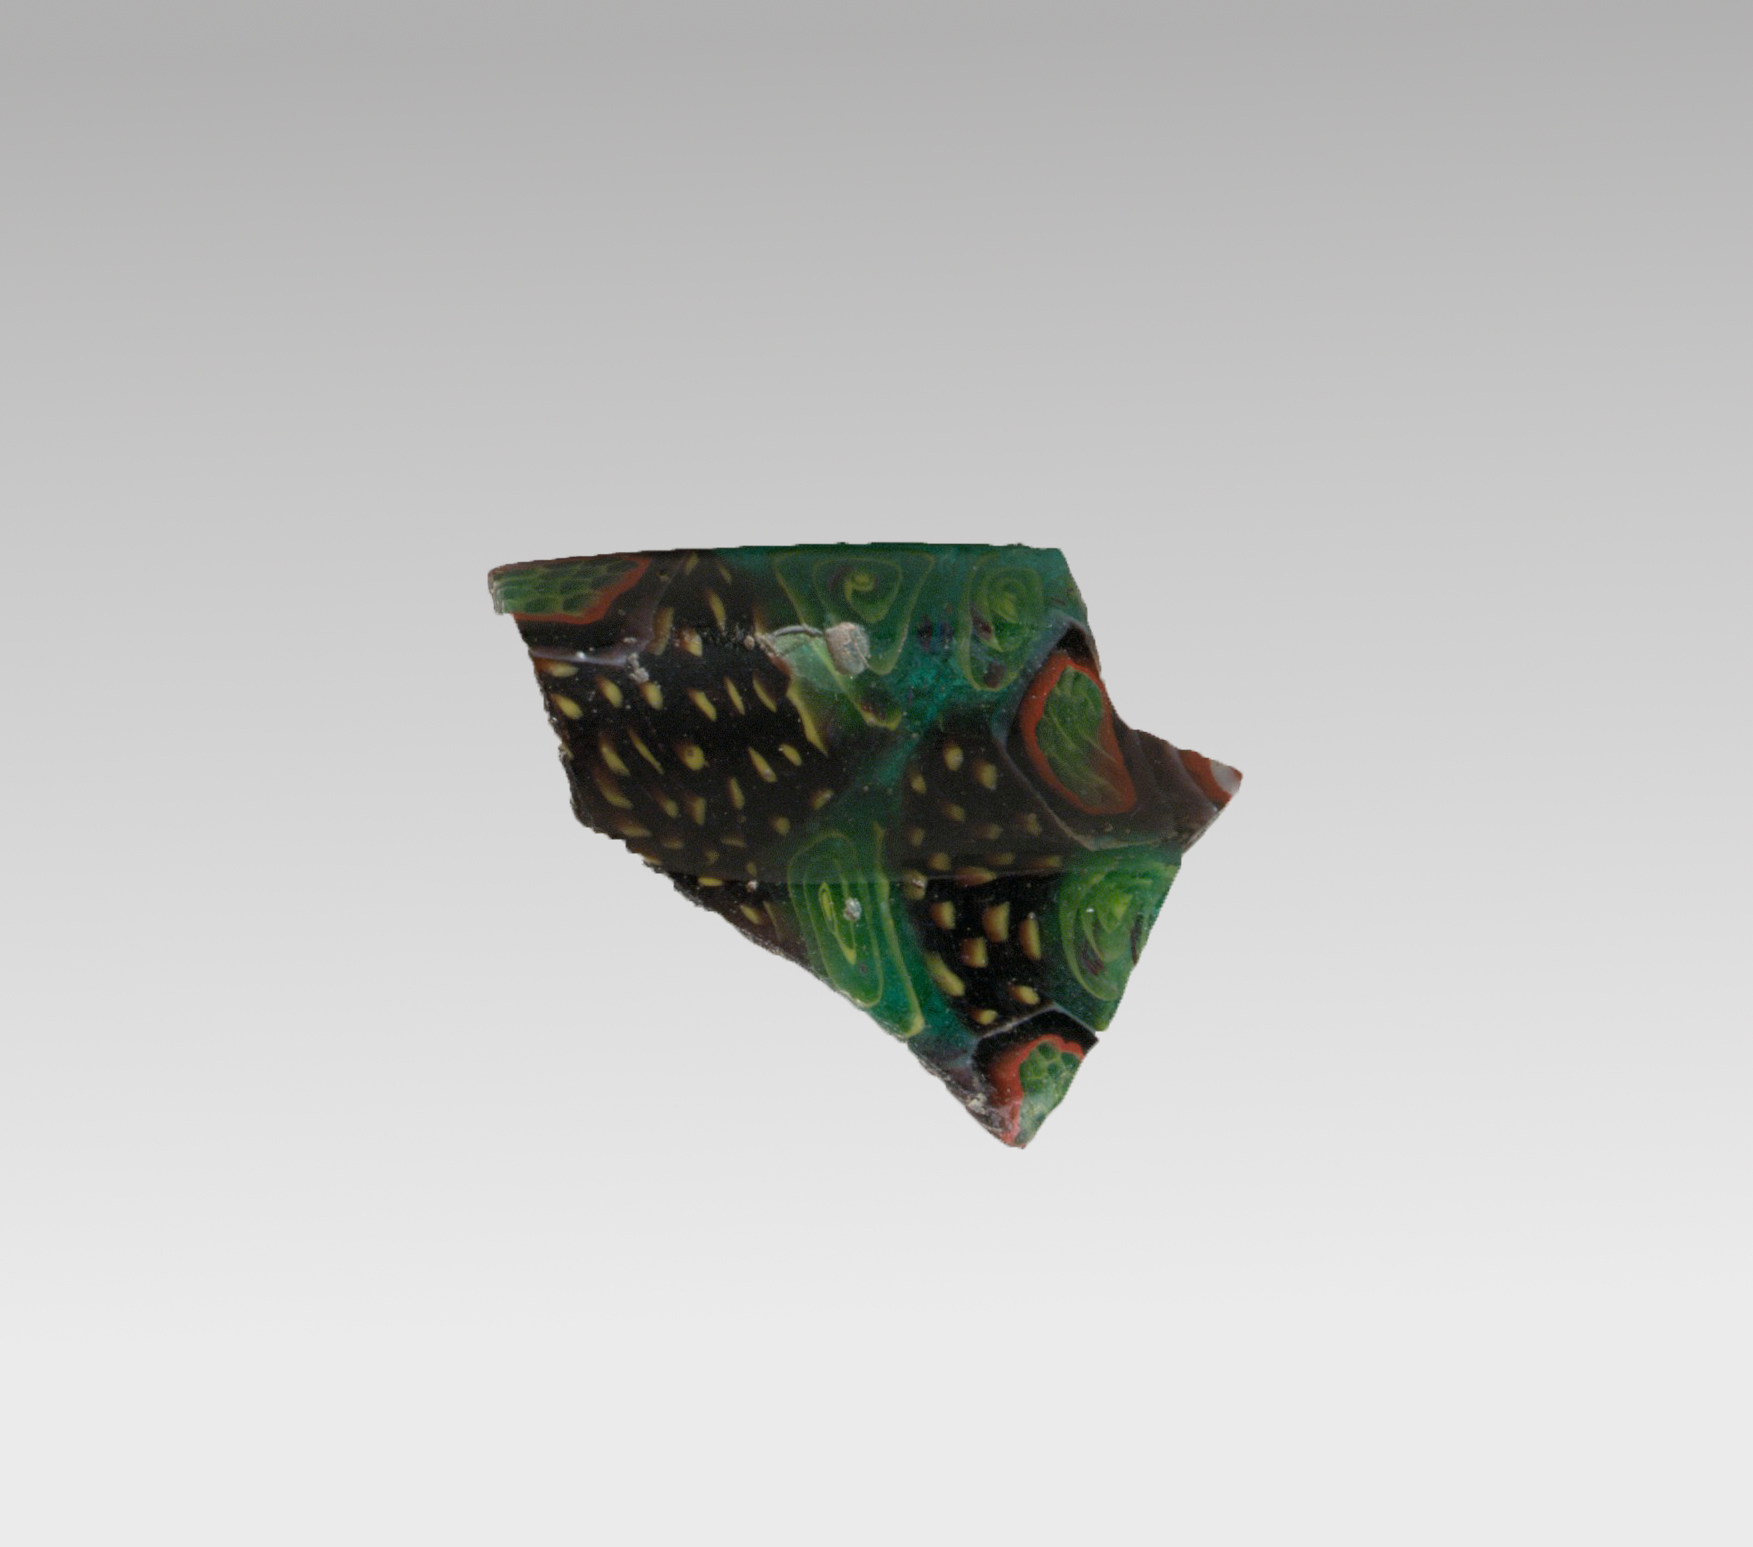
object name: fragment, mosaic bowl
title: Glass mosaic carinated bowl fragment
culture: roman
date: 34 BCE-33 CE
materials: glass